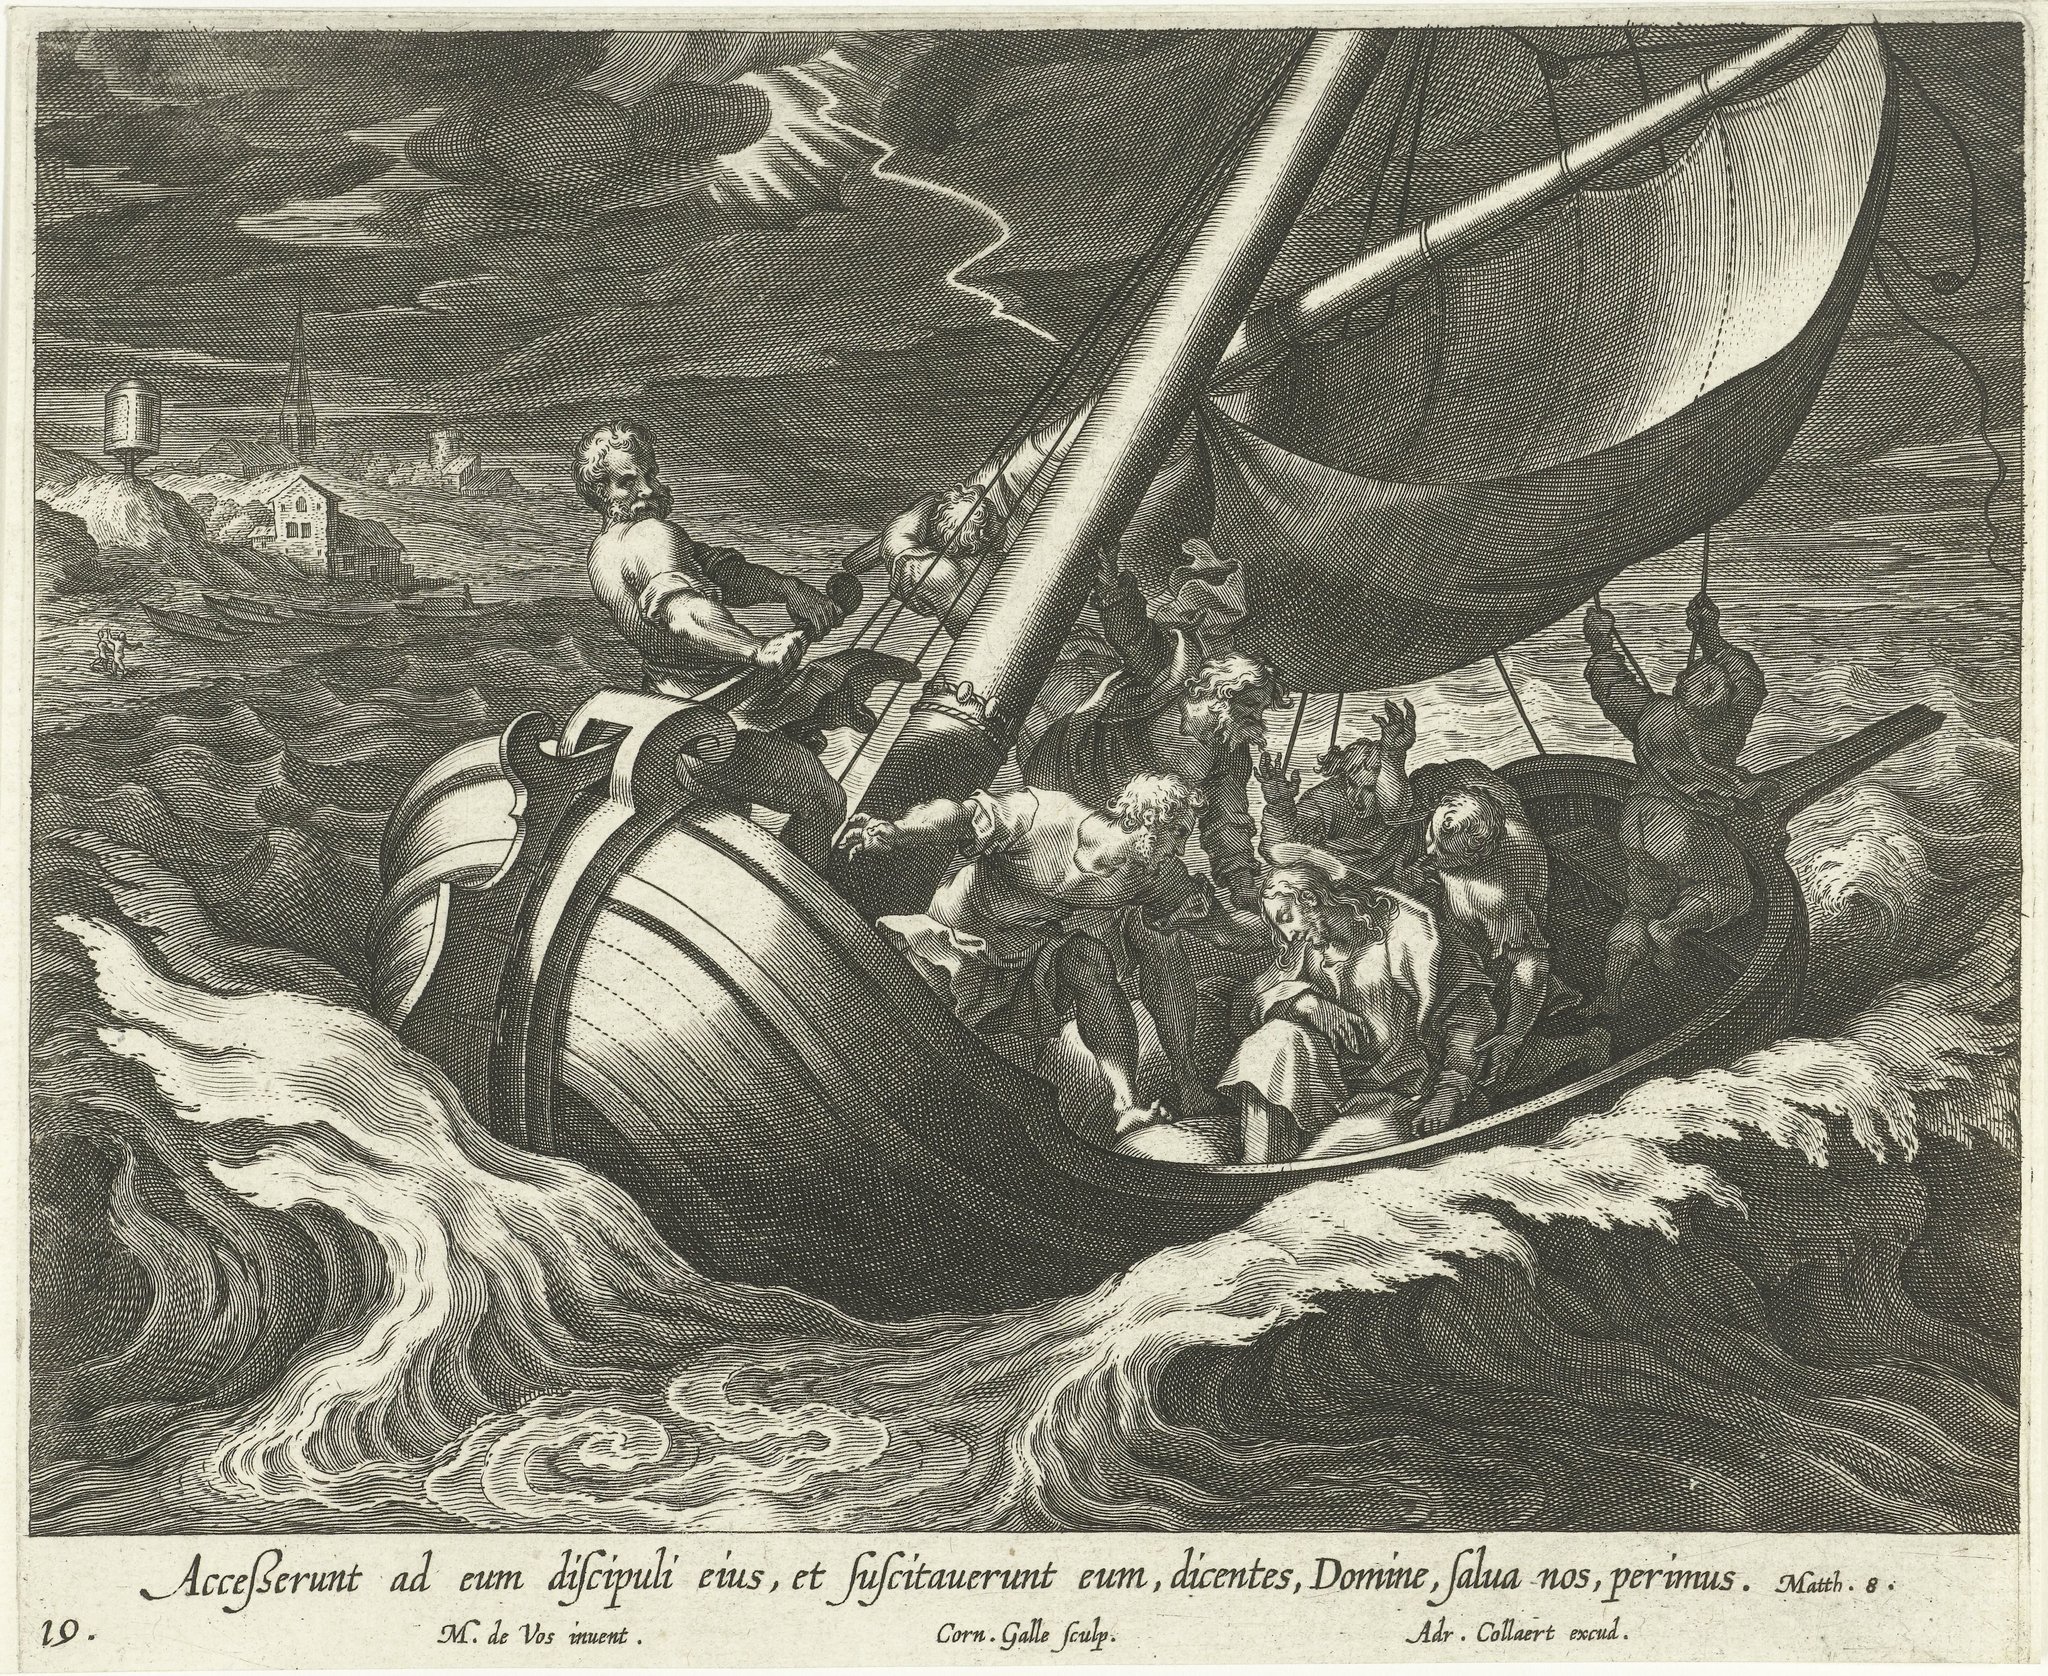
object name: print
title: Leven, passie en wederopstanding van Christus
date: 1598-1618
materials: paper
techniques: engraving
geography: antwerp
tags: christ in a boat with the apostles, talking or sleeping, the apostles awake christ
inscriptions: collector's mark: Lugt 2228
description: Christus en zijn apostelen steken het Meer van Galilea over. Het stormt en de apostelen proberen Christus wakker te maken (Matteüs 8:23-27). De prent heeft een Latijns onderschrift. De prent maakt deel uit van een serie over het leven van Christus.